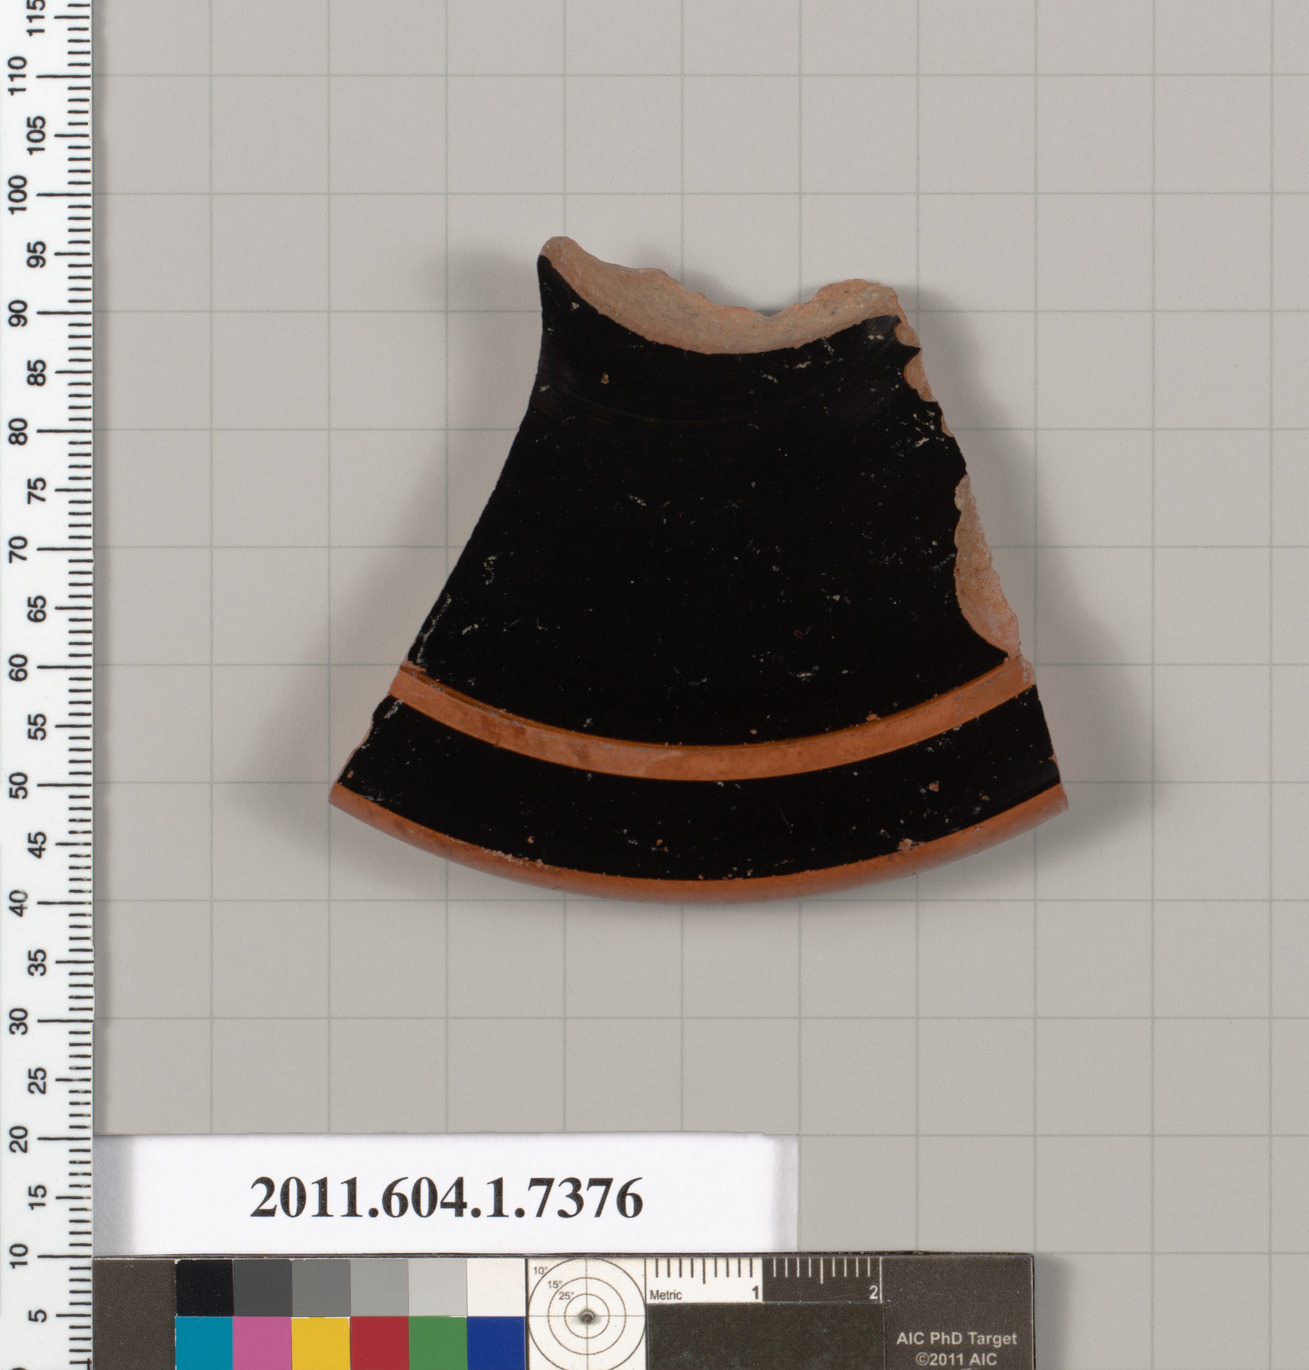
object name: kylix fragment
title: Terracotta fragment of a kylix (drinking cup)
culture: greek, attic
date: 500-480 BCE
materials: terracotta